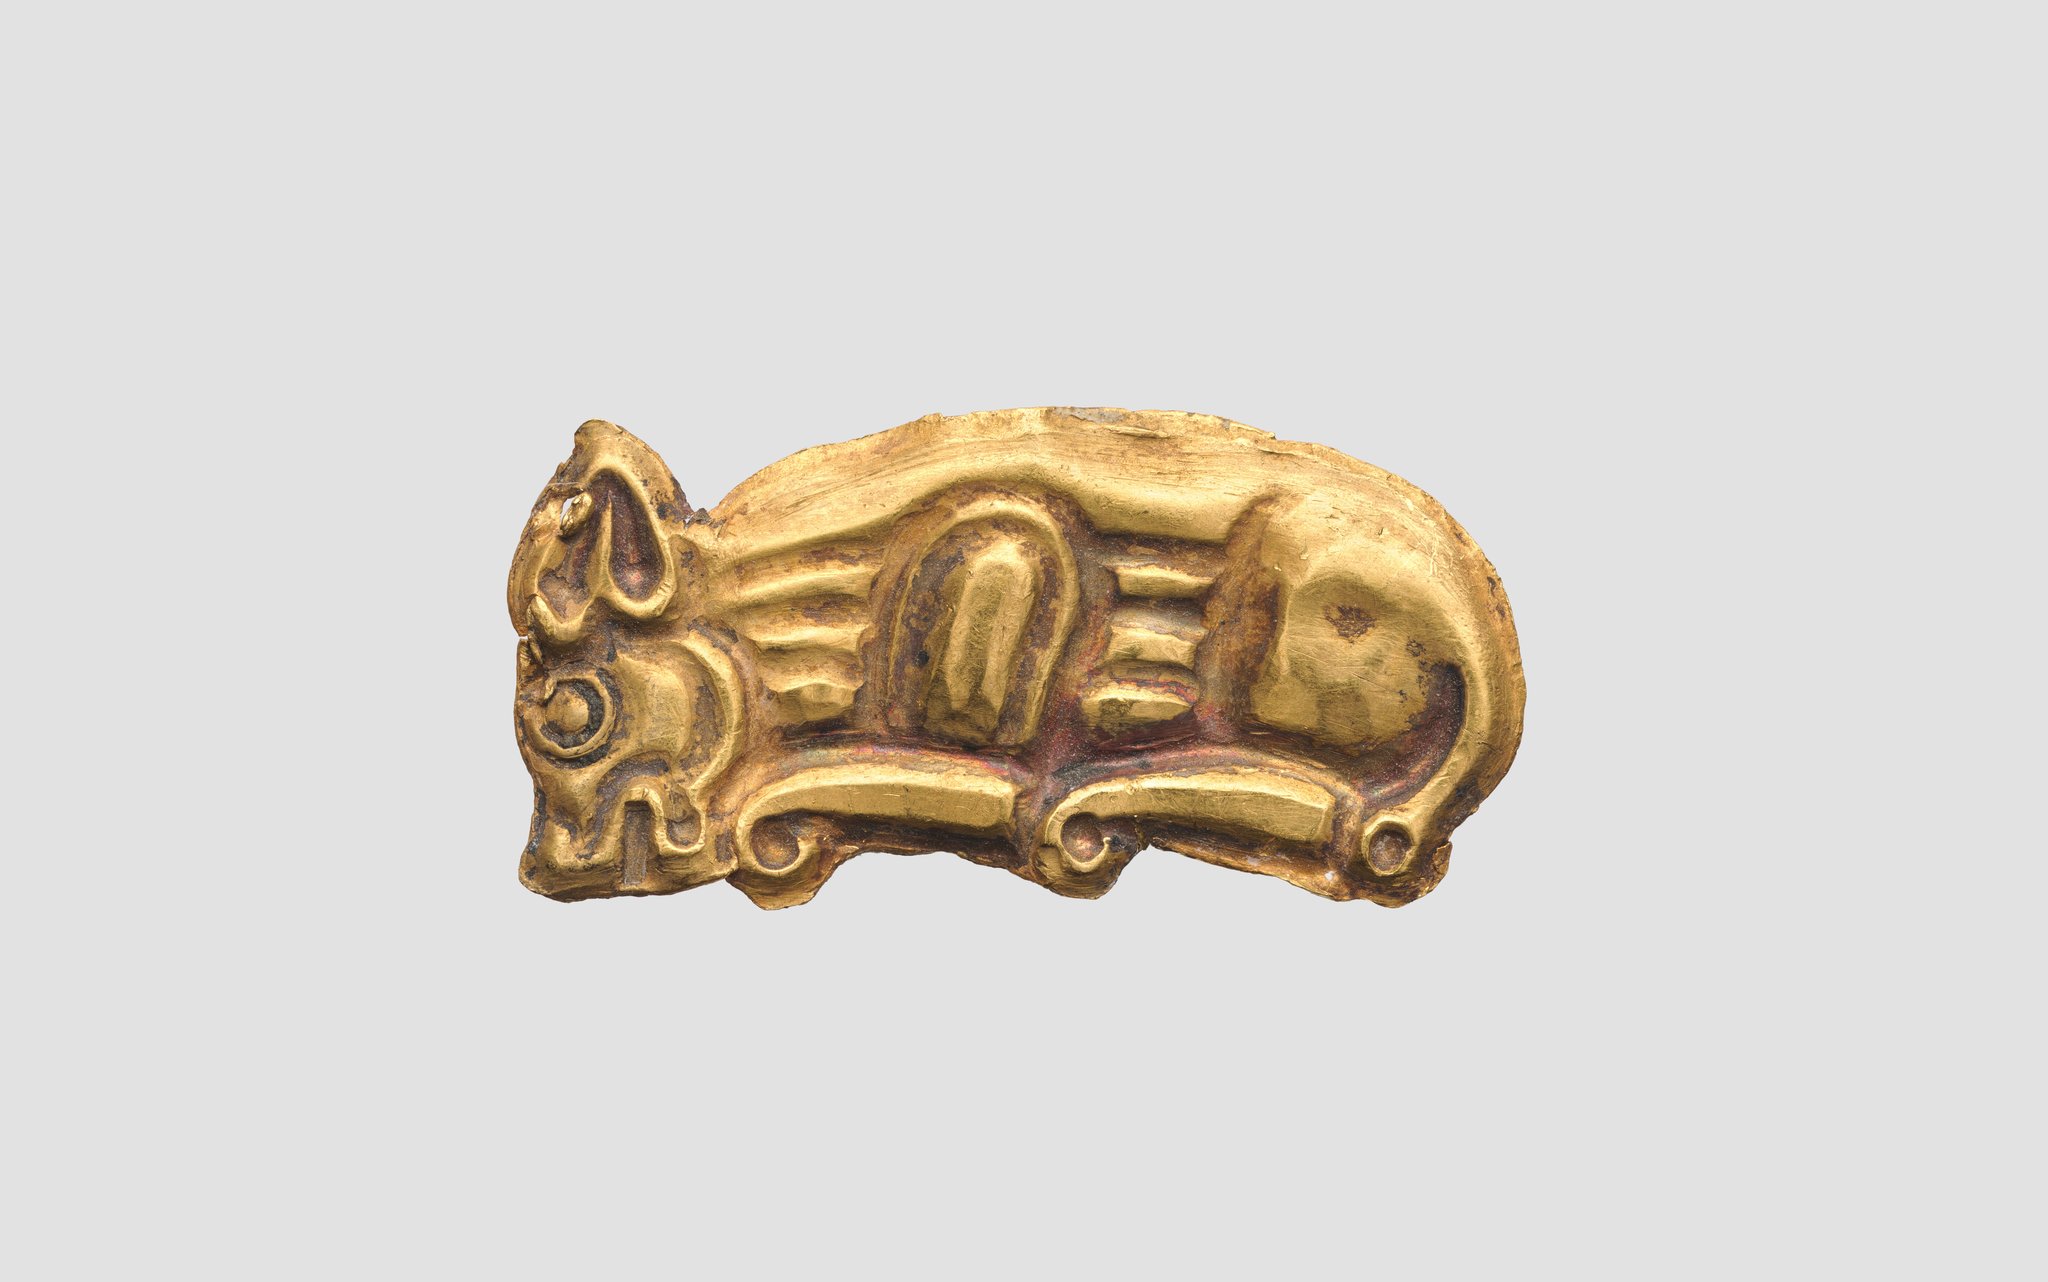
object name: inlay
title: Inlay for a plate in the form of a feline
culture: scythian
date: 700-601 BCE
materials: gold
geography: iran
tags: animals